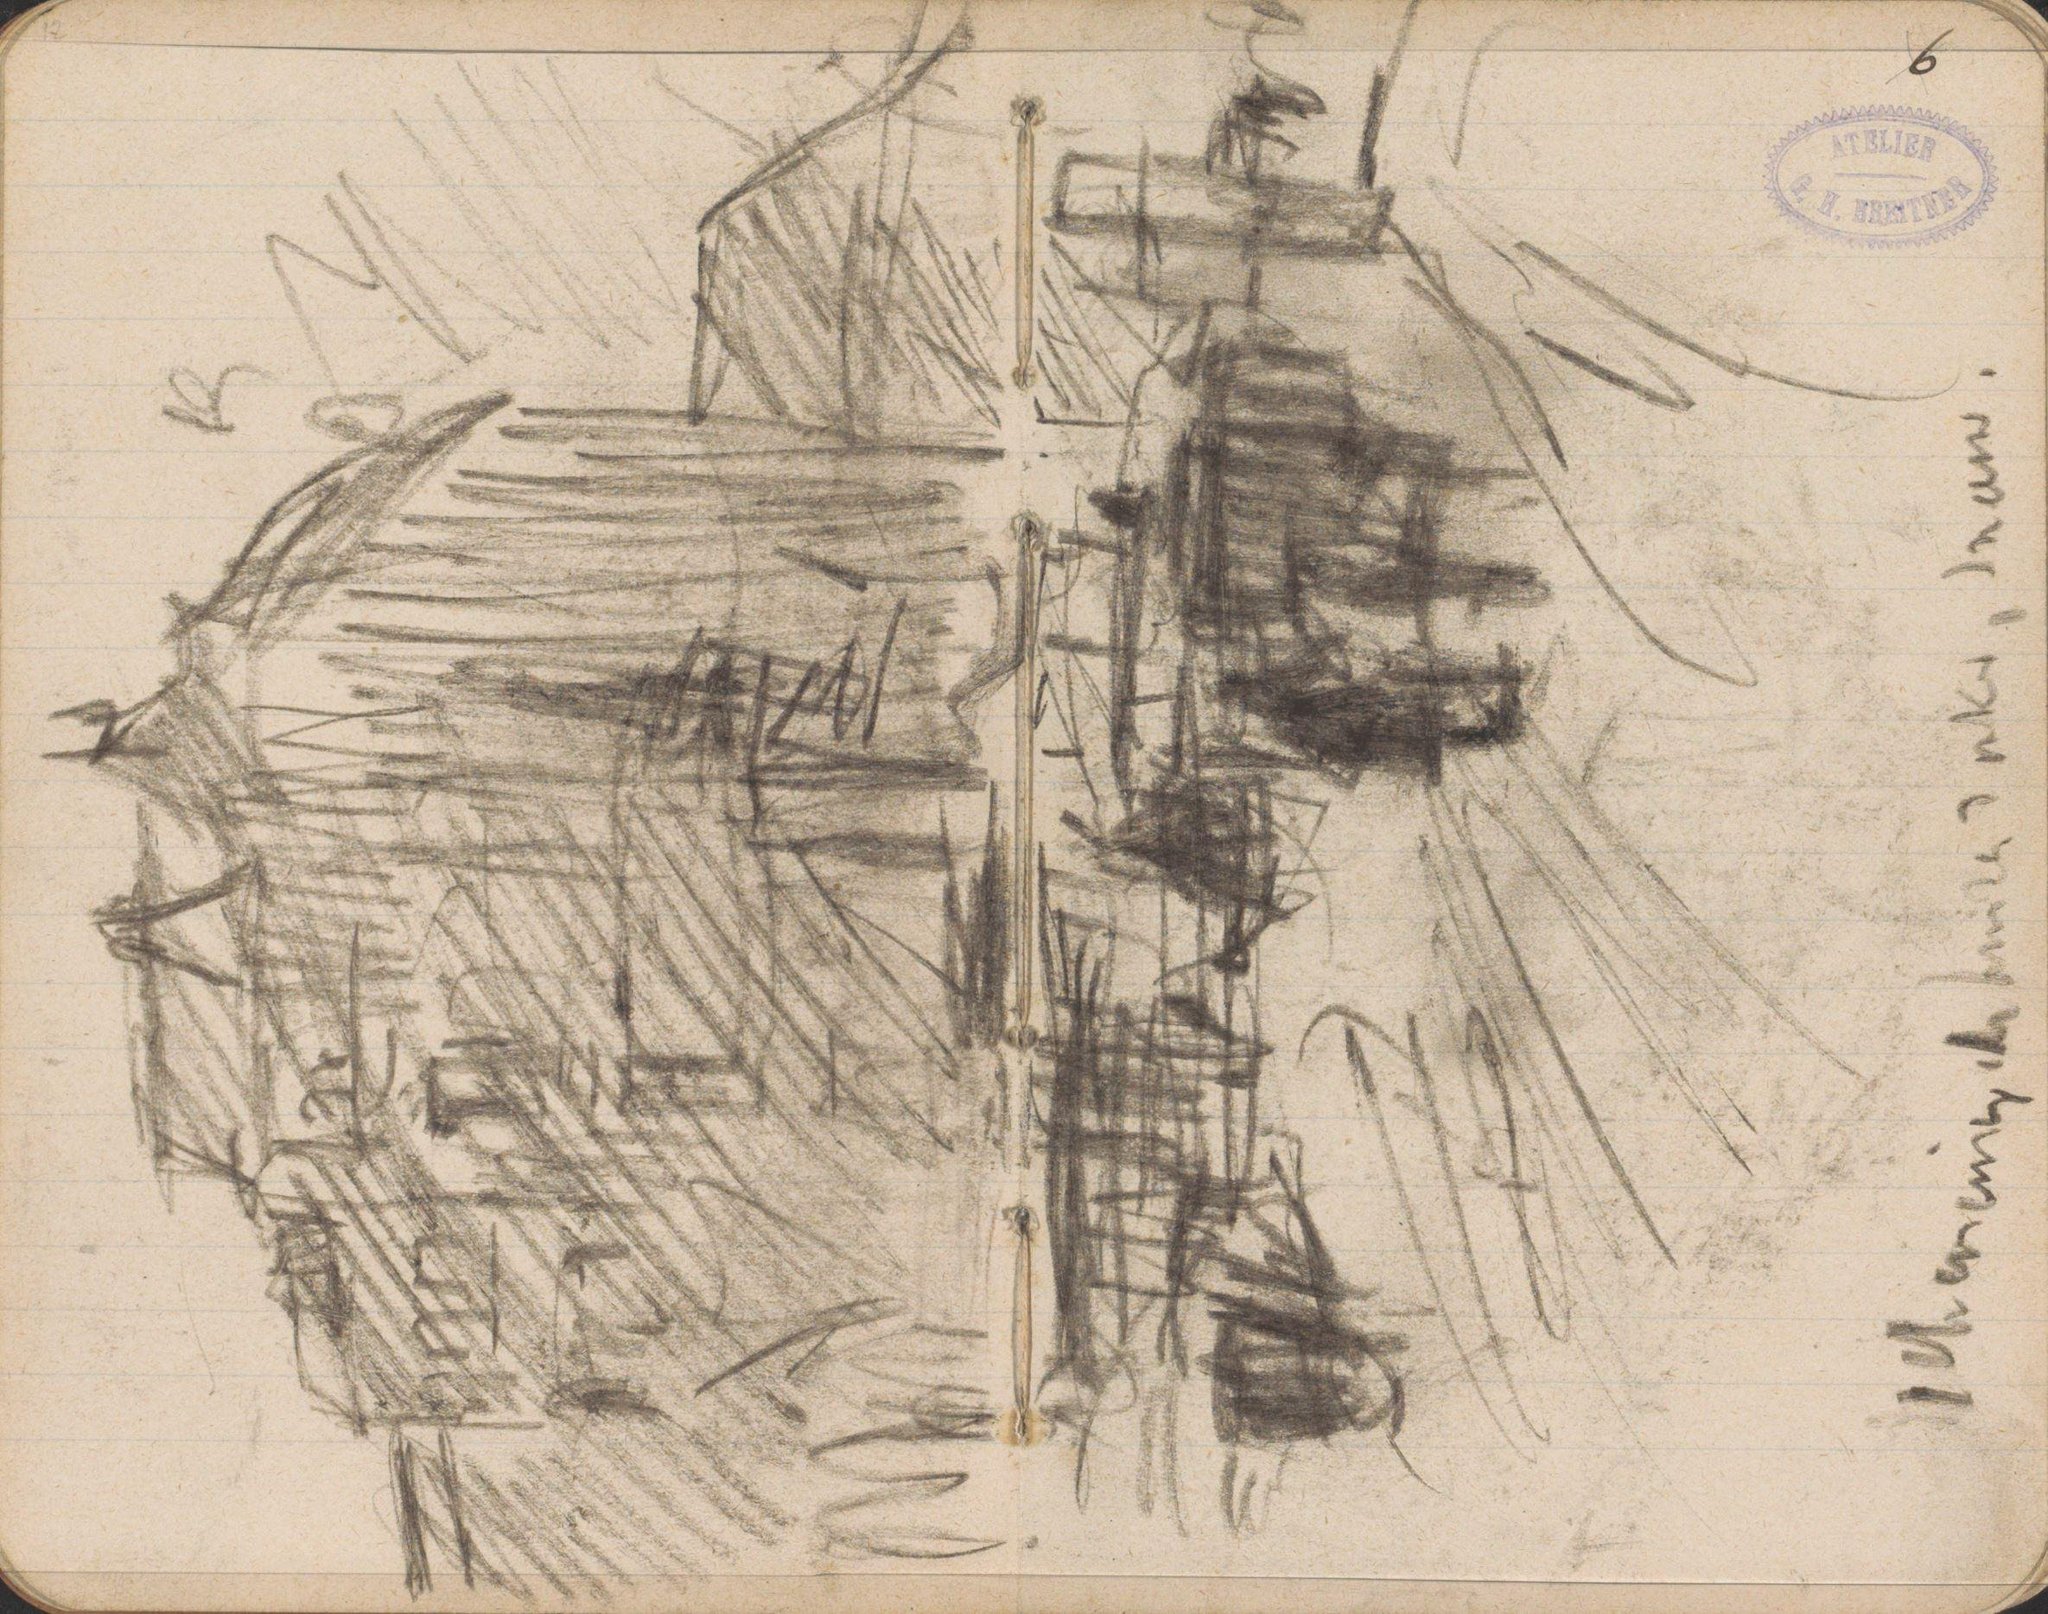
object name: sketchbook leaf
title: Stadsgezicht, mogelijk rooiwerkzaamheden aan de Laan van Meerdervoort te Den Haag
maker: george hendrik breitner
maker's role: draughtsman, painter, print maker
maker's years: 1857-1923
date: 1882-1885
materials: chalk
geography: the hague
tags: civic architecture; edifices; dwellings, street (+ city(-scape) with figures, staffage)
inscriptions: workshop stamp: Lugt 291d, annotation: ‘Schemering, de huizen donker, sneeuw.’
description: Pagina 12 en pagina 13 uit een schetsboek met 34 bladen.